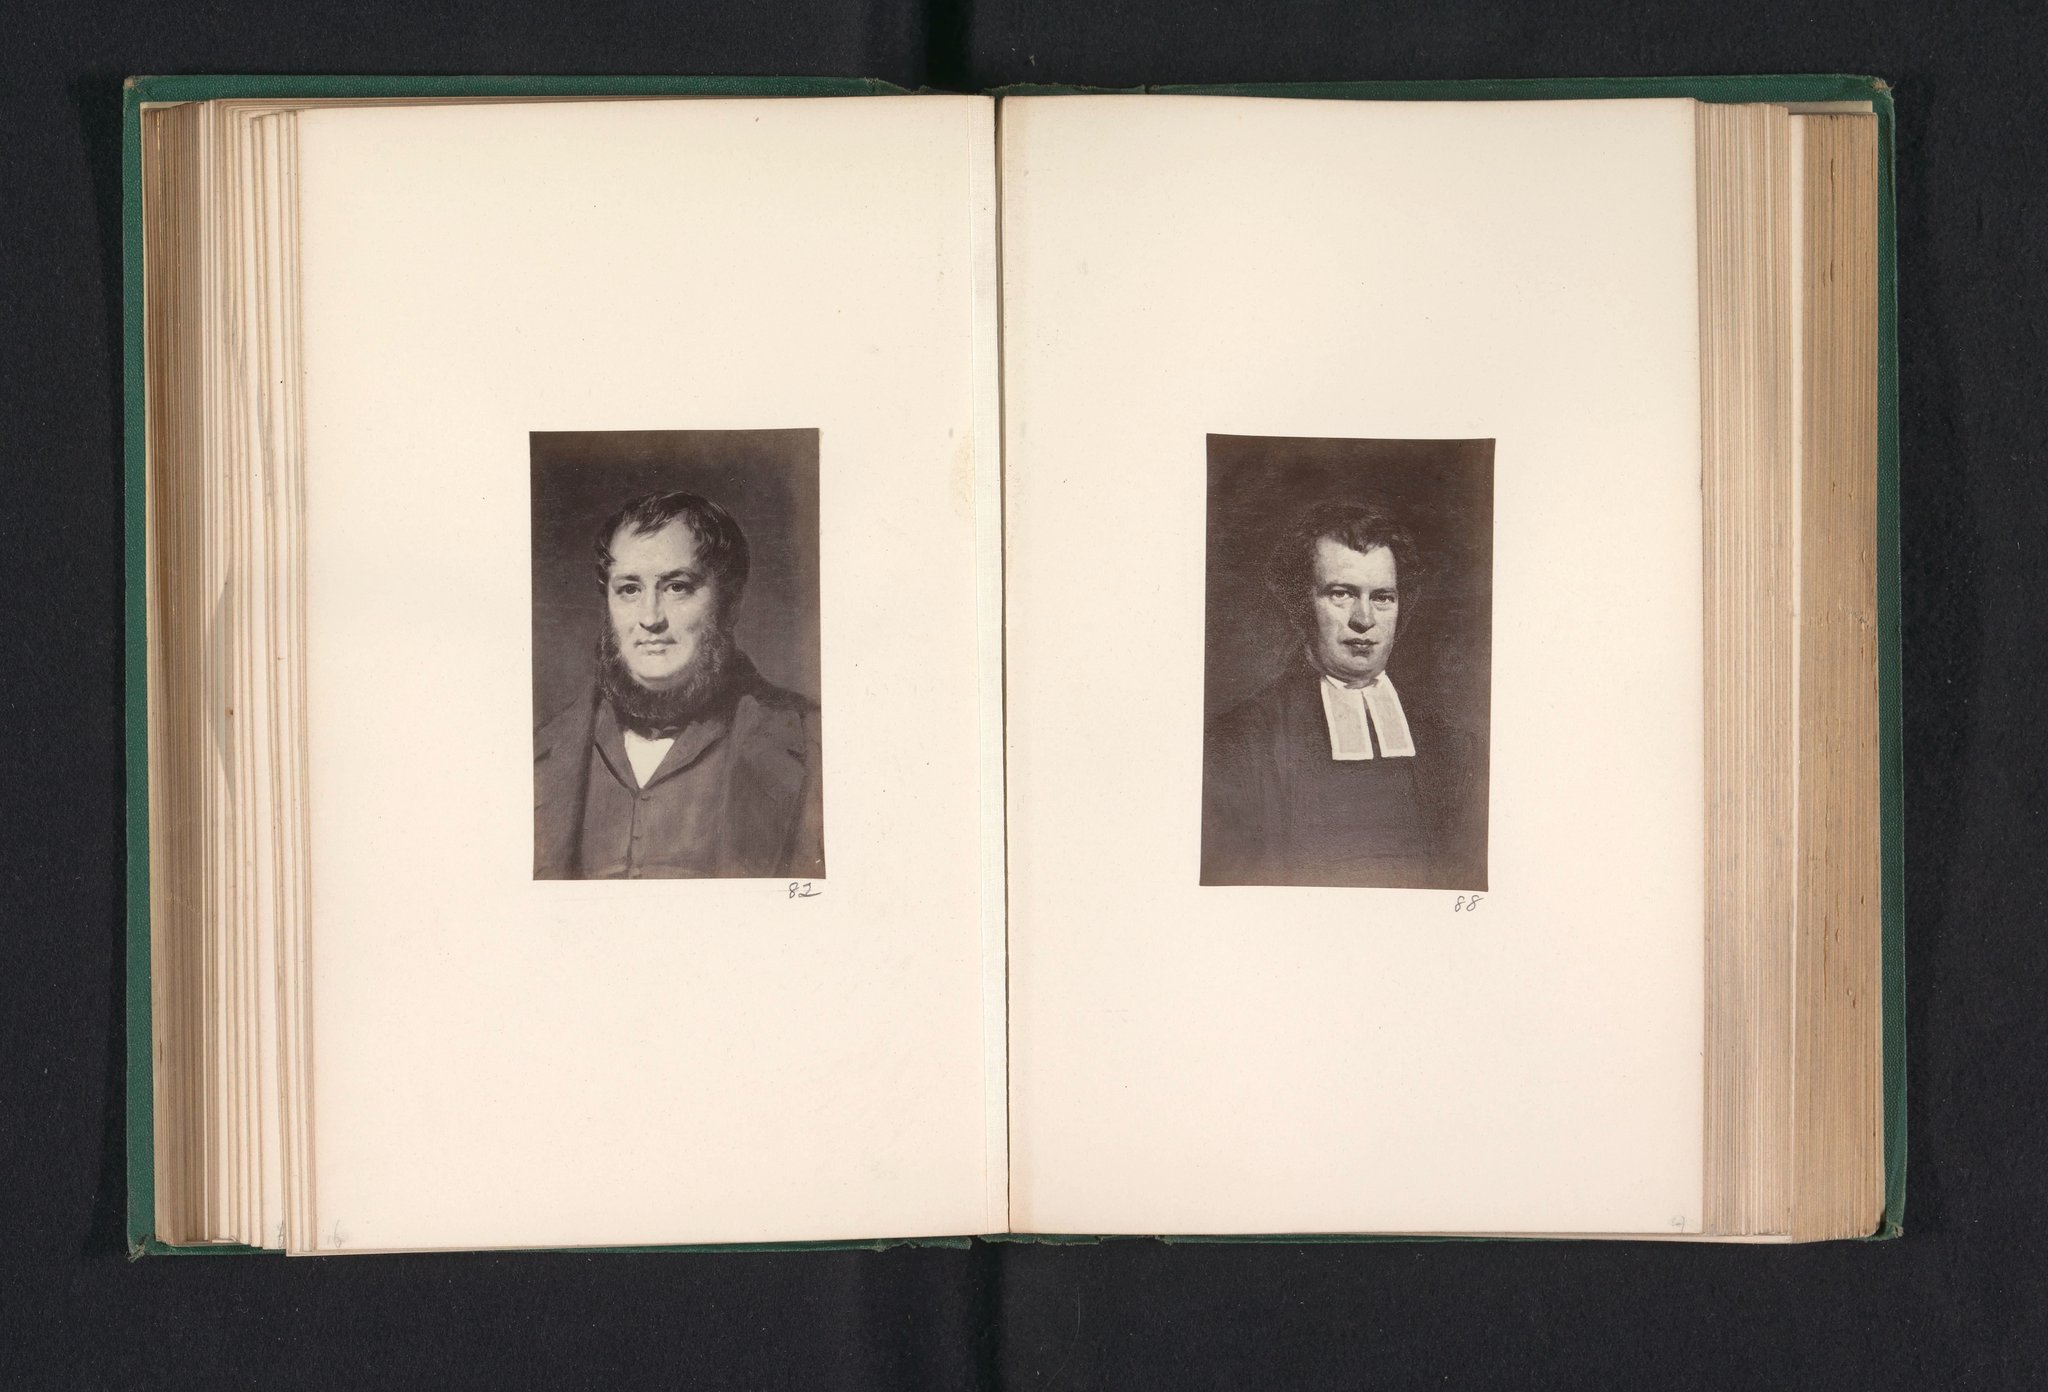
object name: reproduction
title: Fotoreproductie van een schilderij, voorstellende een portret van Gavin Struthers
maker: thomas annan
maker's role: fotograaf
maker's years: 1829-1887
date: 1863-1868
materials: photographic support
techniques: albumen print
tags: historical persons (portraits and scenes from the life) (+ (full) bust portrait)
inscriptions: number: ‘88’